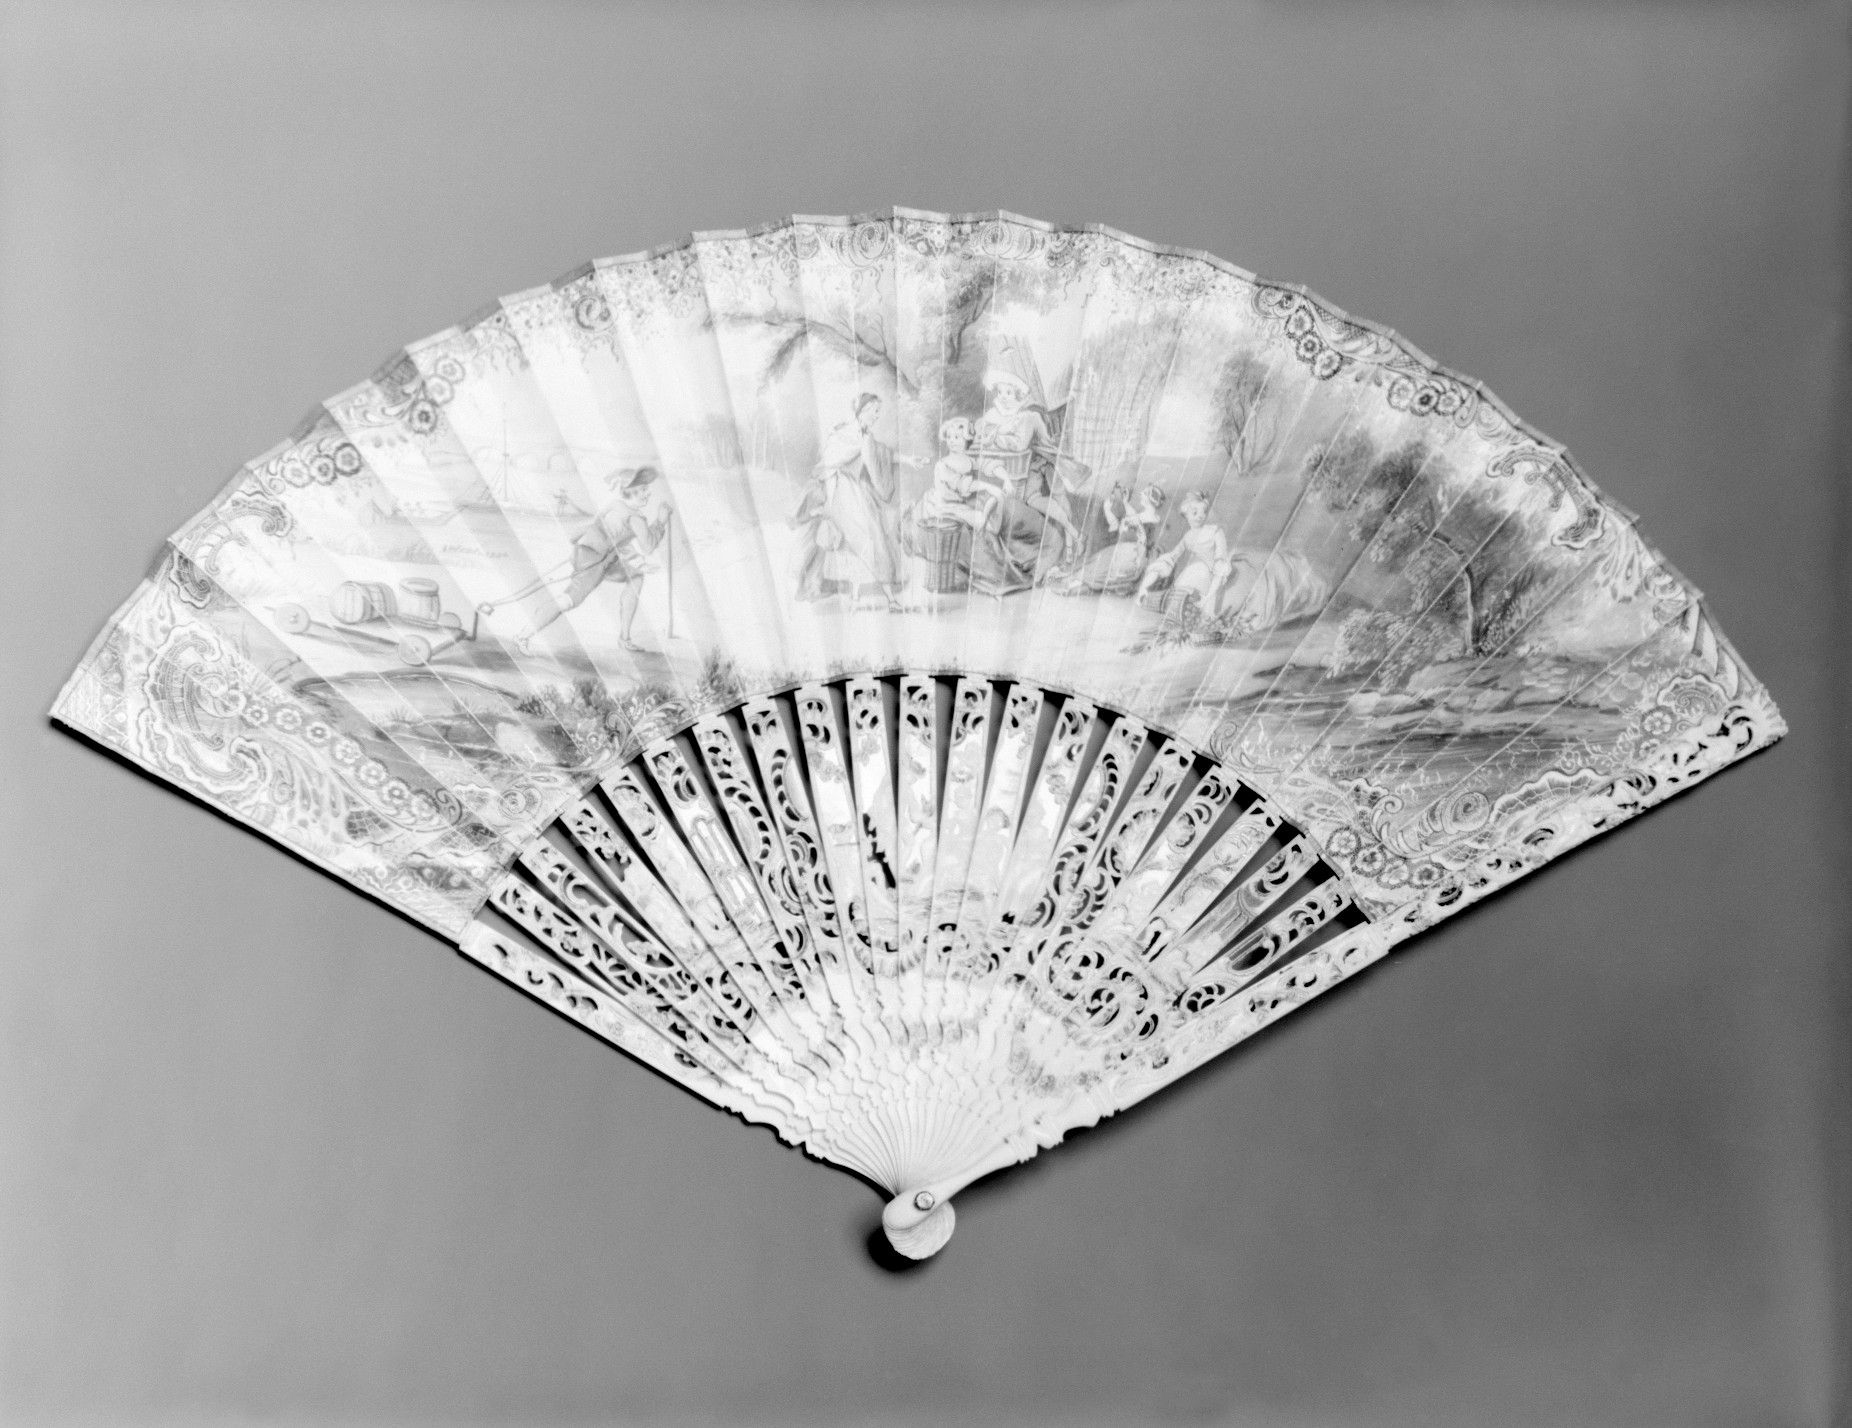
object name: fan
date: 1701-1800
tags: men,women